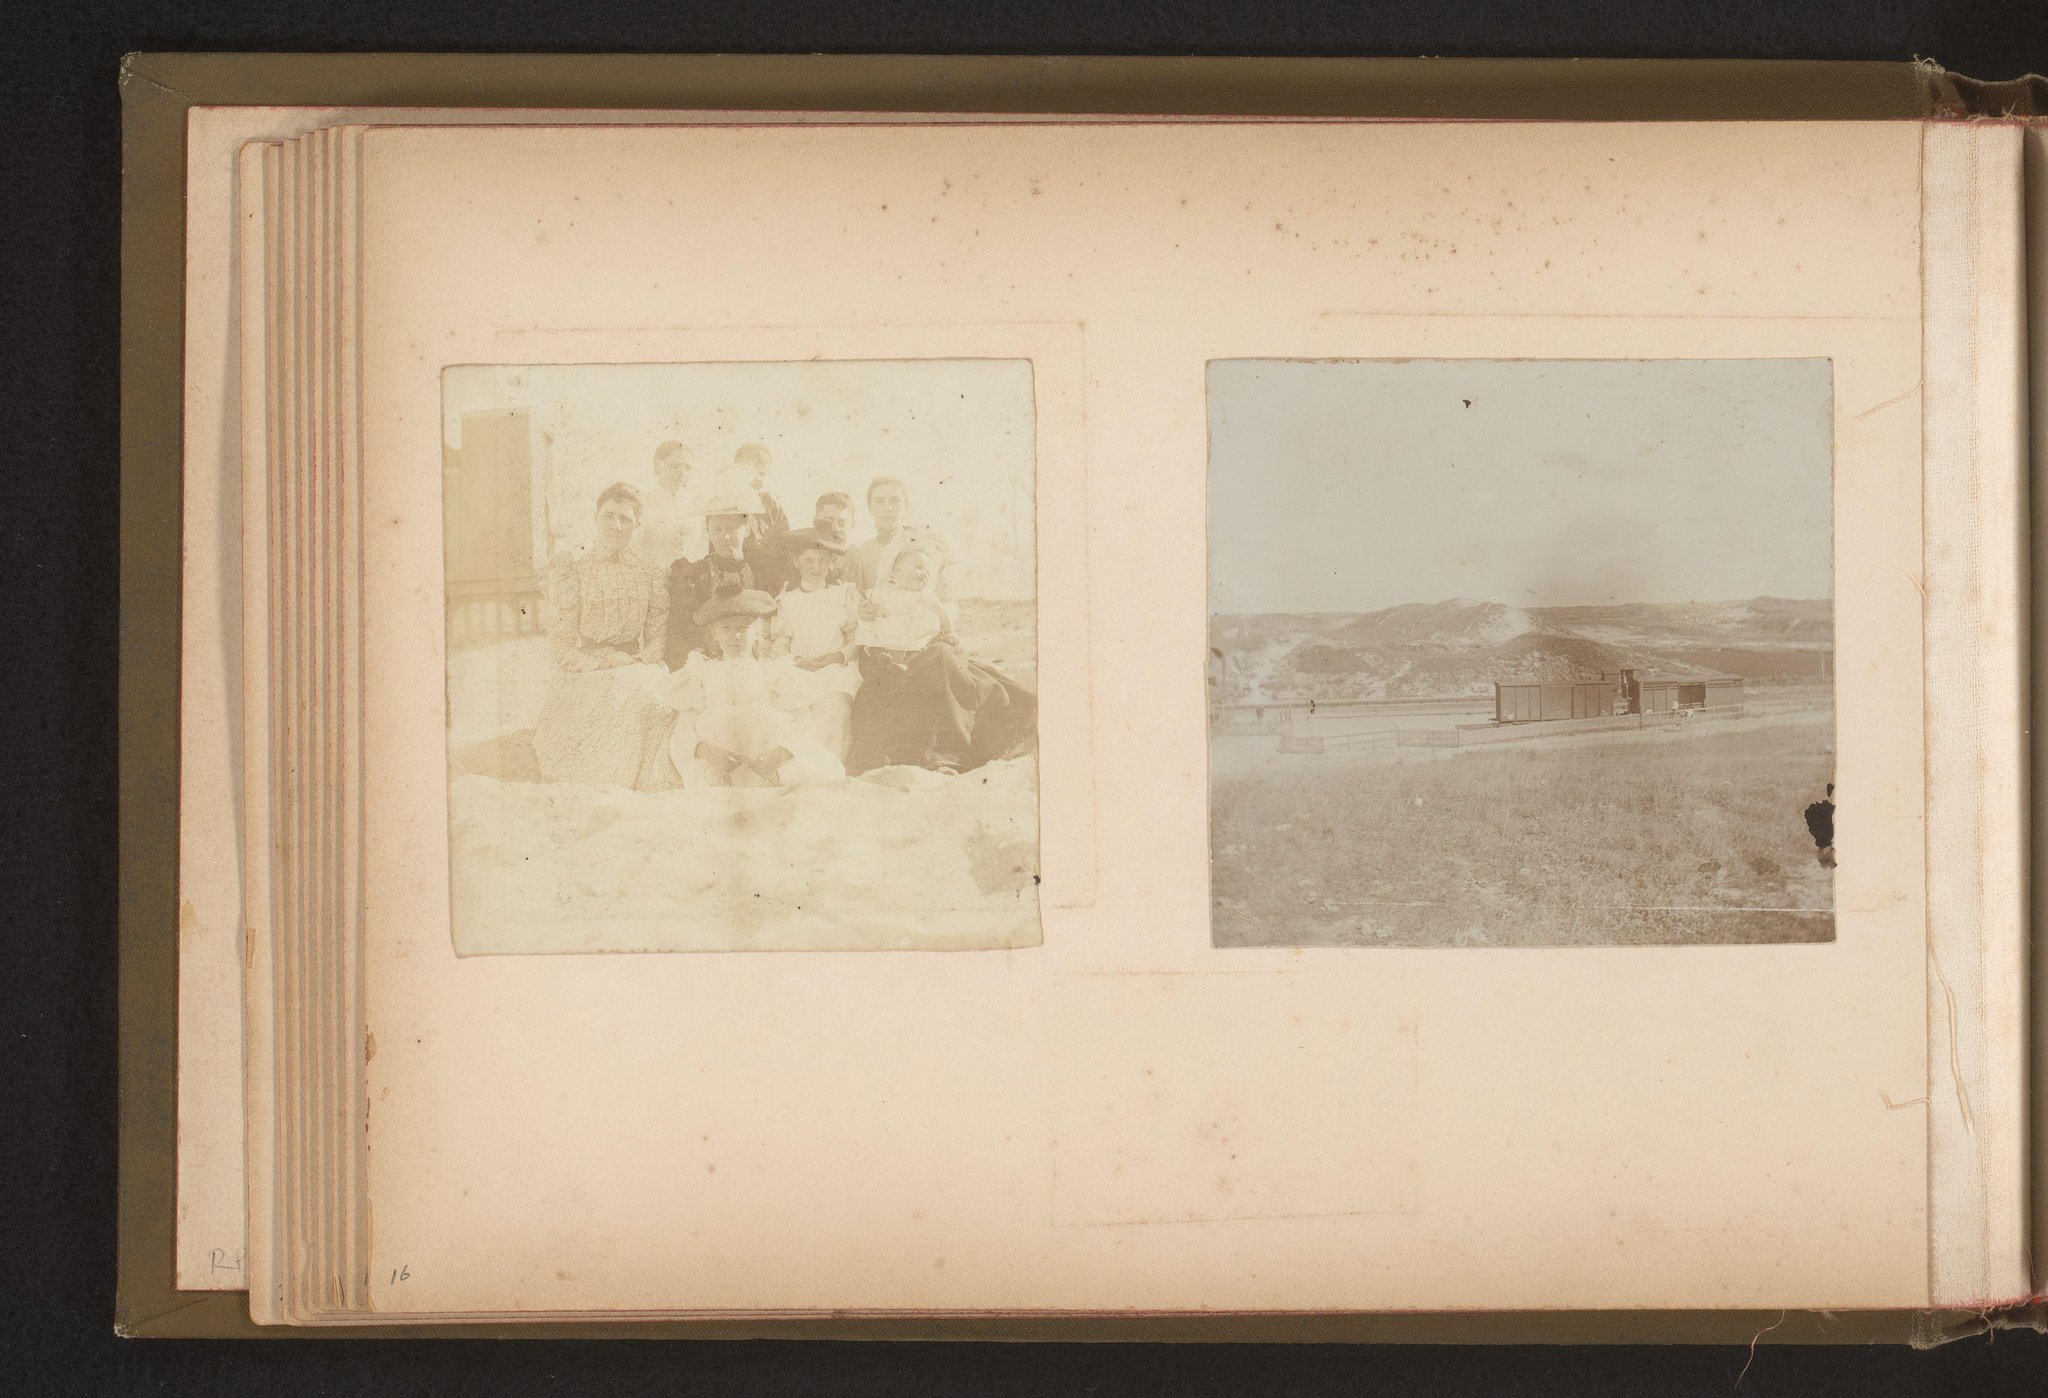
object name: album leaf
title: Twee foto's, een groepsportret op het strand en goederenwagons in de duinen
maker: Anonymous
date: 1895-1910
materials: paper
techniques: albumen print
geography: zandvoort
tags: freight train, family group, especially parents with their child(ren), dunes (sea not visible); in the dunes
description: Deze foto's maken deel uit van een album.